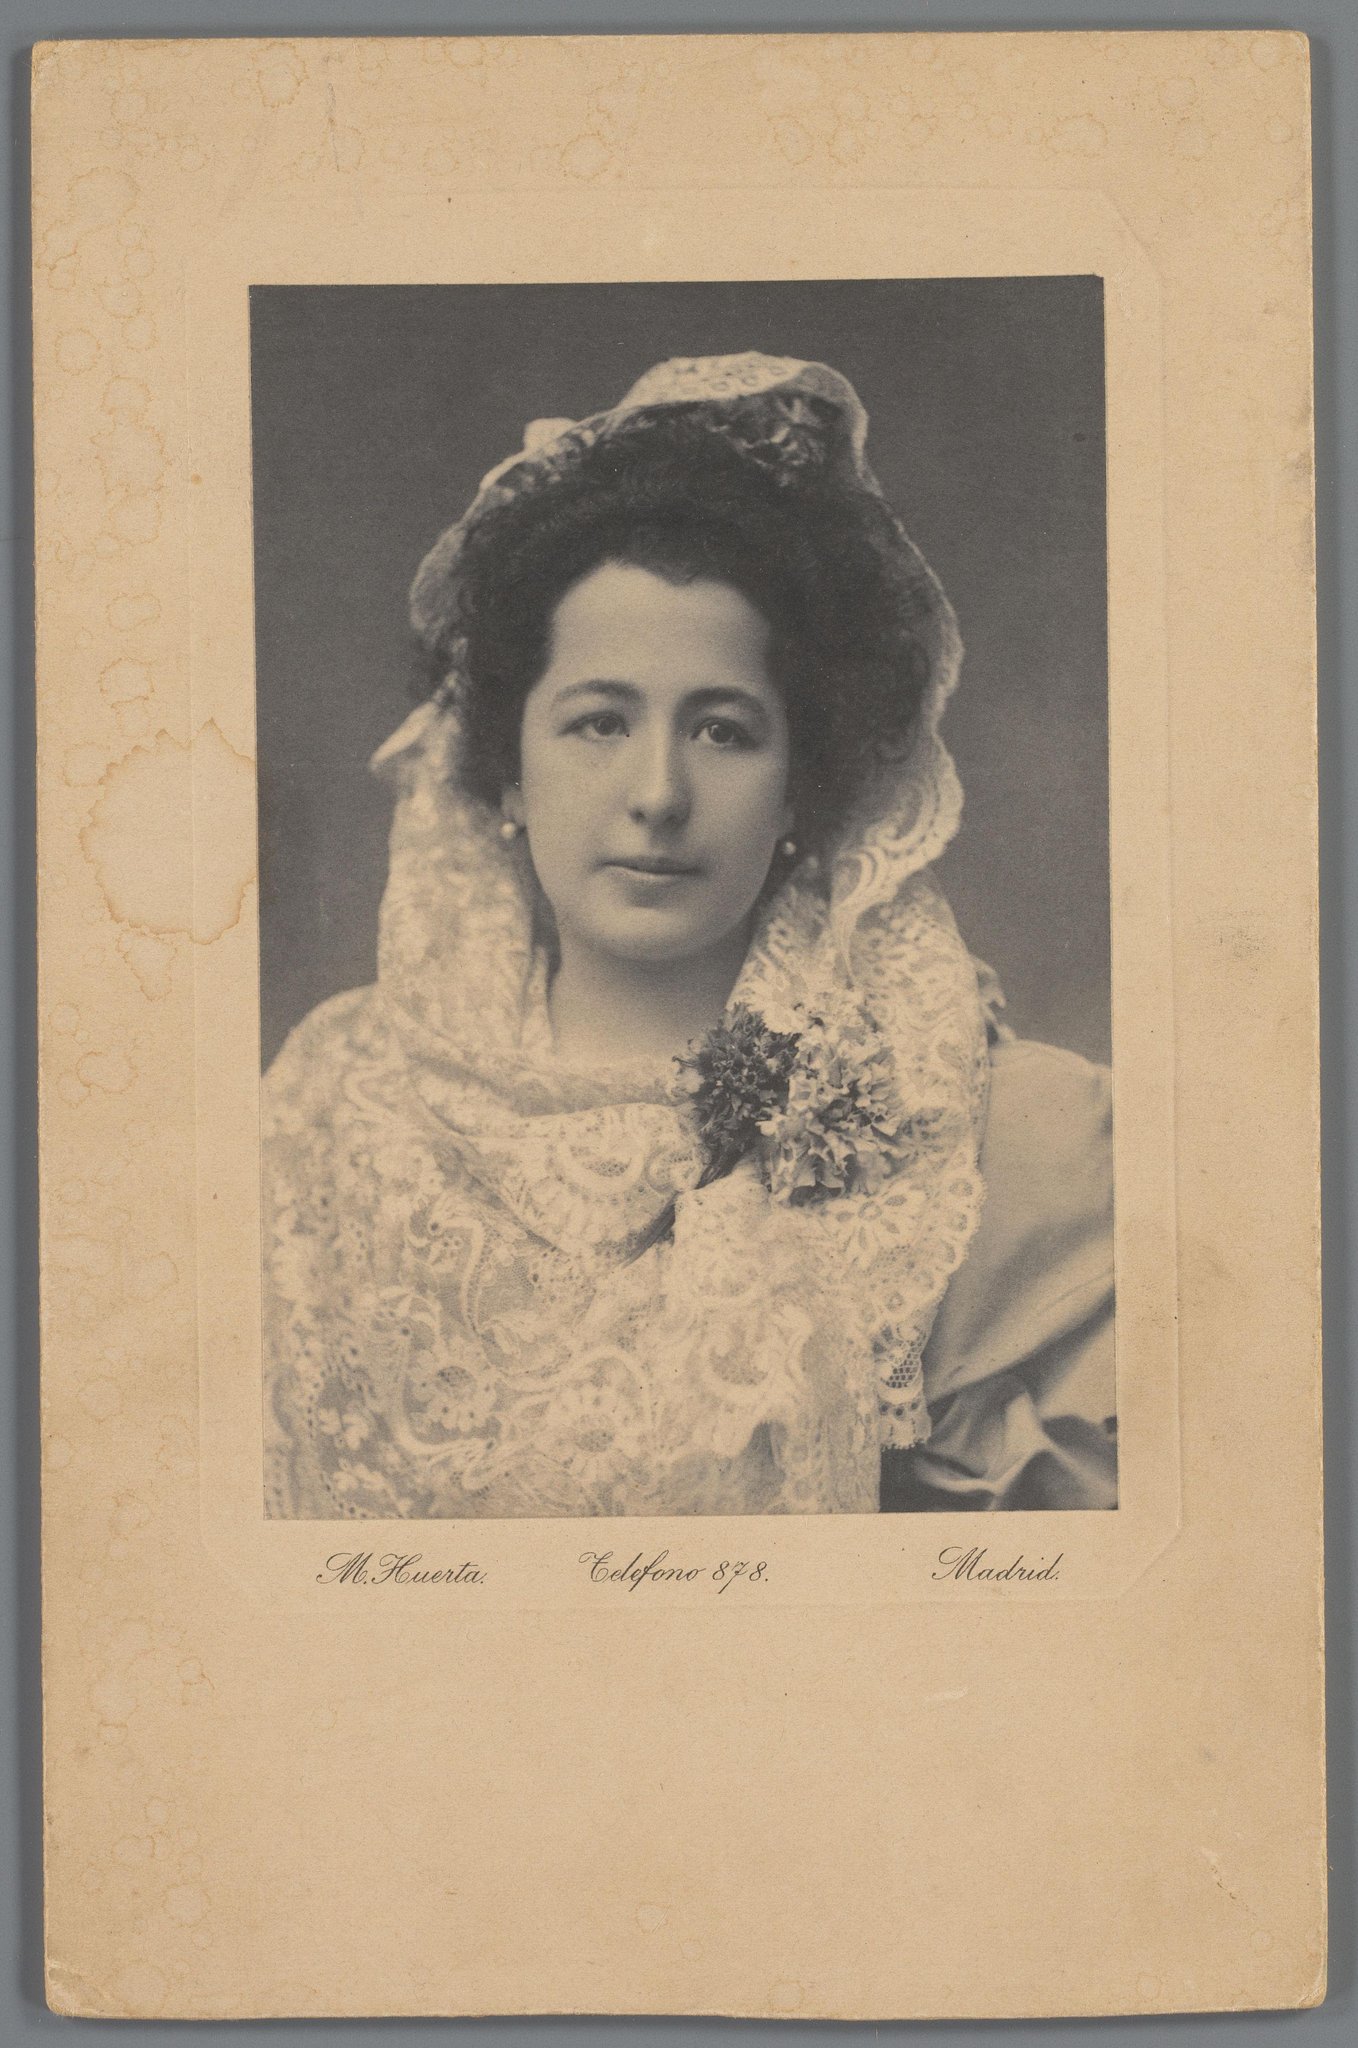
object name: photograph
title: Portret van een onbekende vrouw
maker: m. huerta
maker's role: fotograaf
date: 1873-1920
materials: cardboard, photographic support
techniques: platinum process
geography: madrid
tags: adult woman, anonymous historical person portrayed - bb - woman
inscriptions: inscription: ‘M. Huerta. Telefono 878. Madrid.’